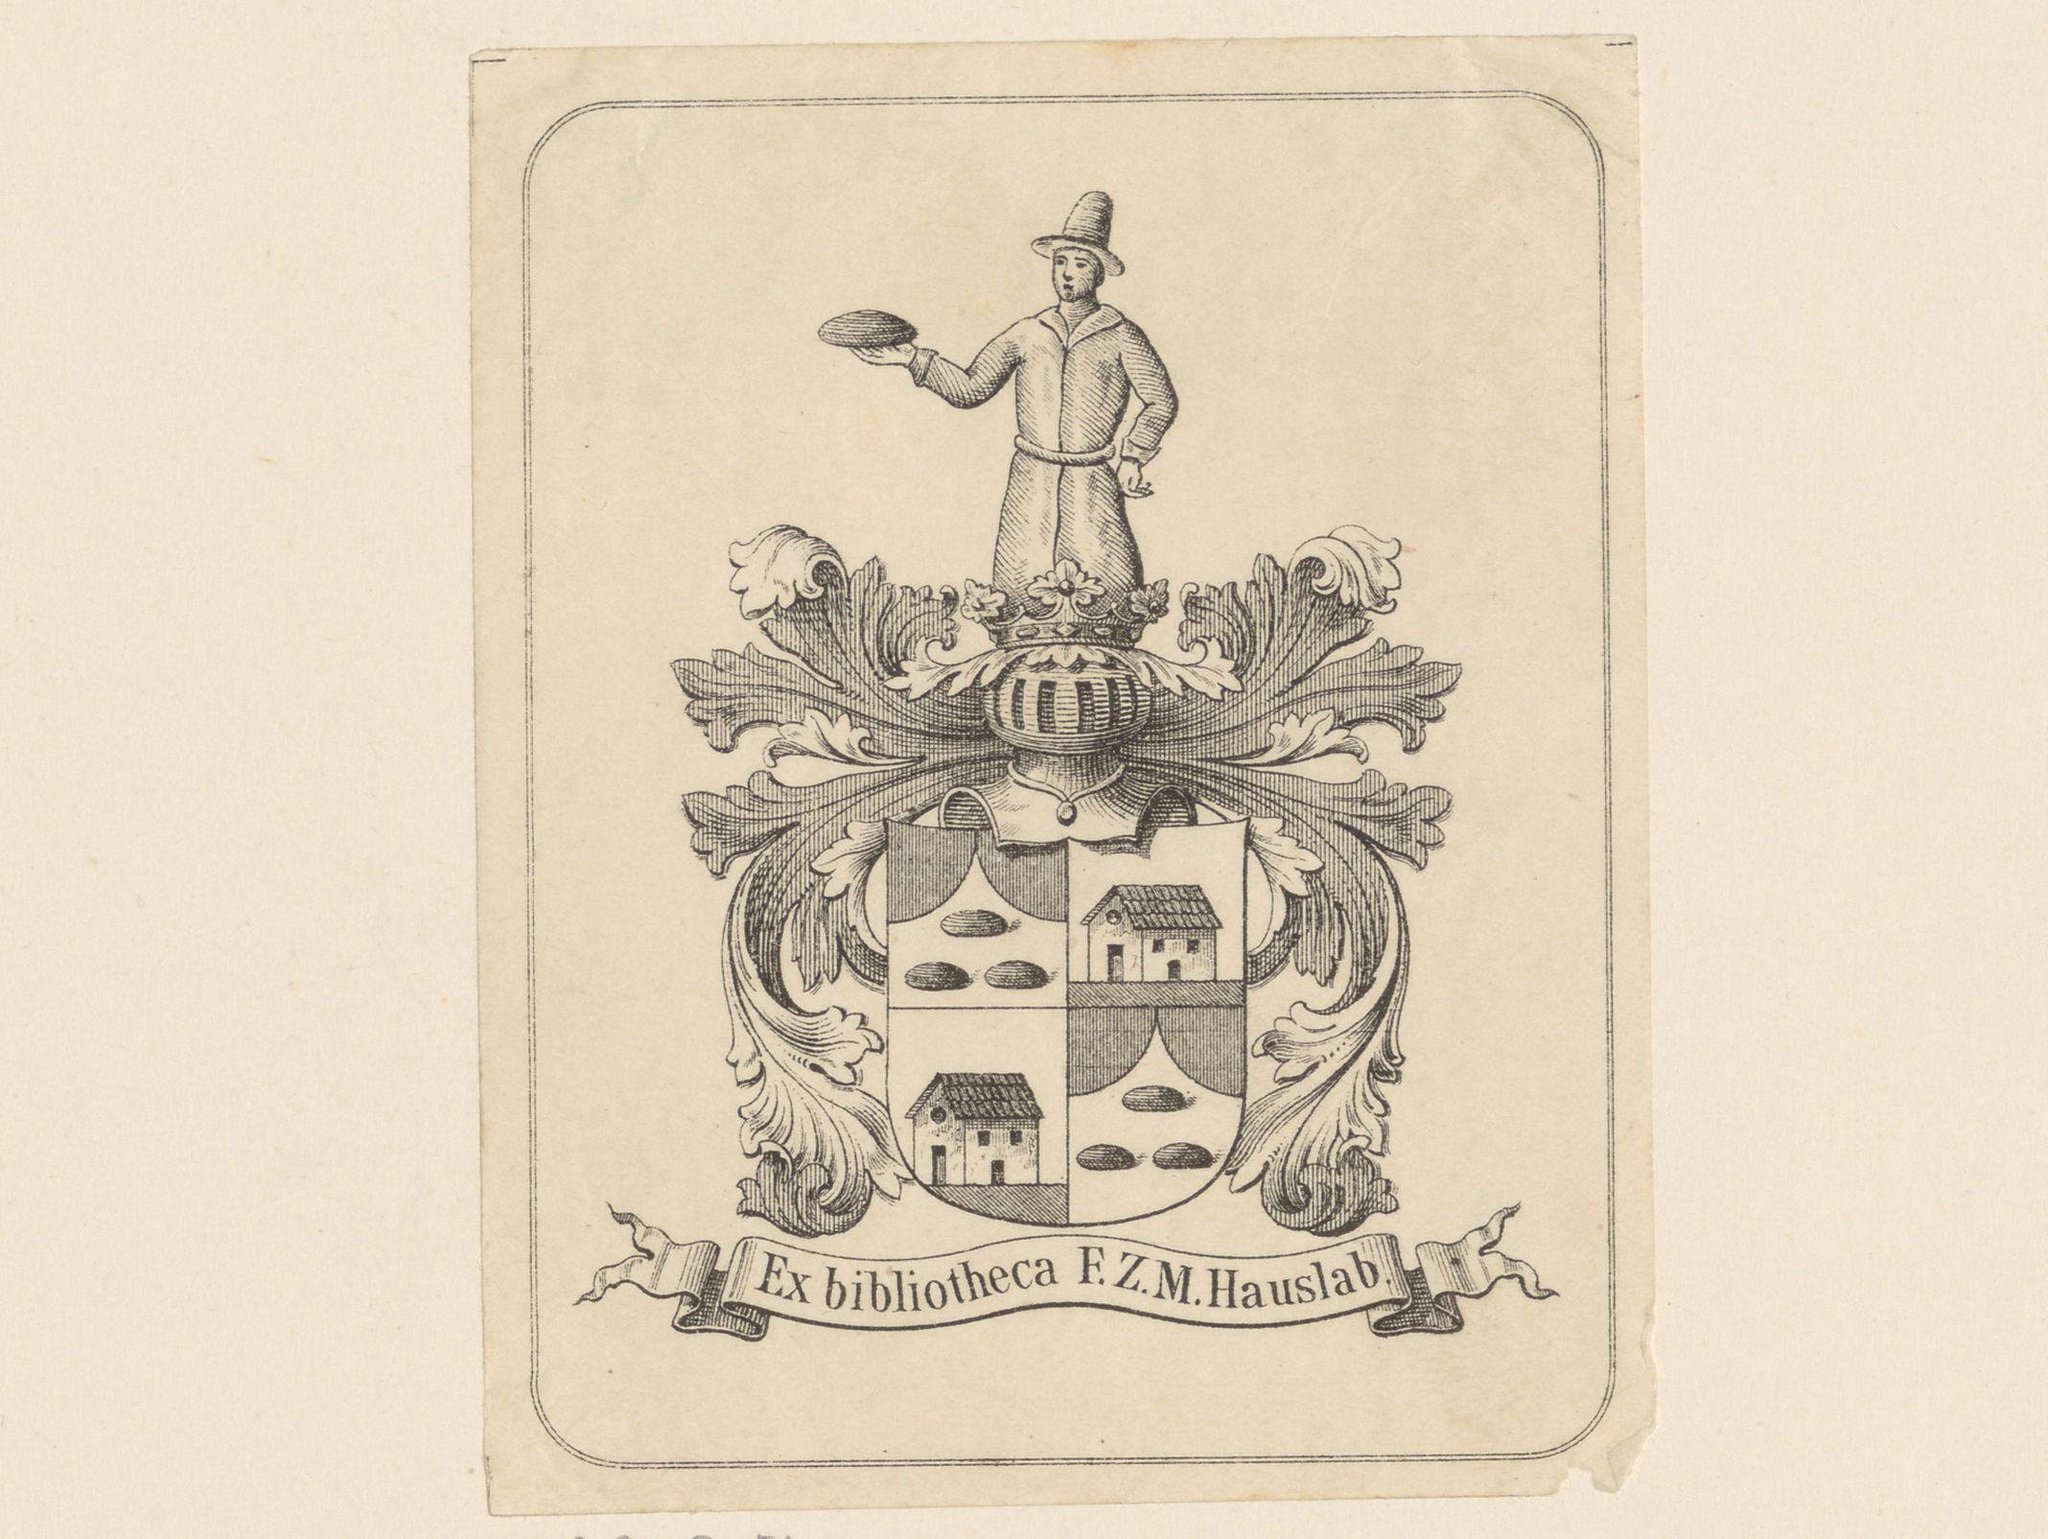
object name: bookplate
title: Ex libris van F.Z.M. Hauslab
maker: Anonymous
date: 1850-1883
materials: paper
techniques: engraving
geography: austria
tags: vienna, standing figure, armorial bearing, heraldry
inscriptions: inscription: ‘Rietstap, 1, 903.’